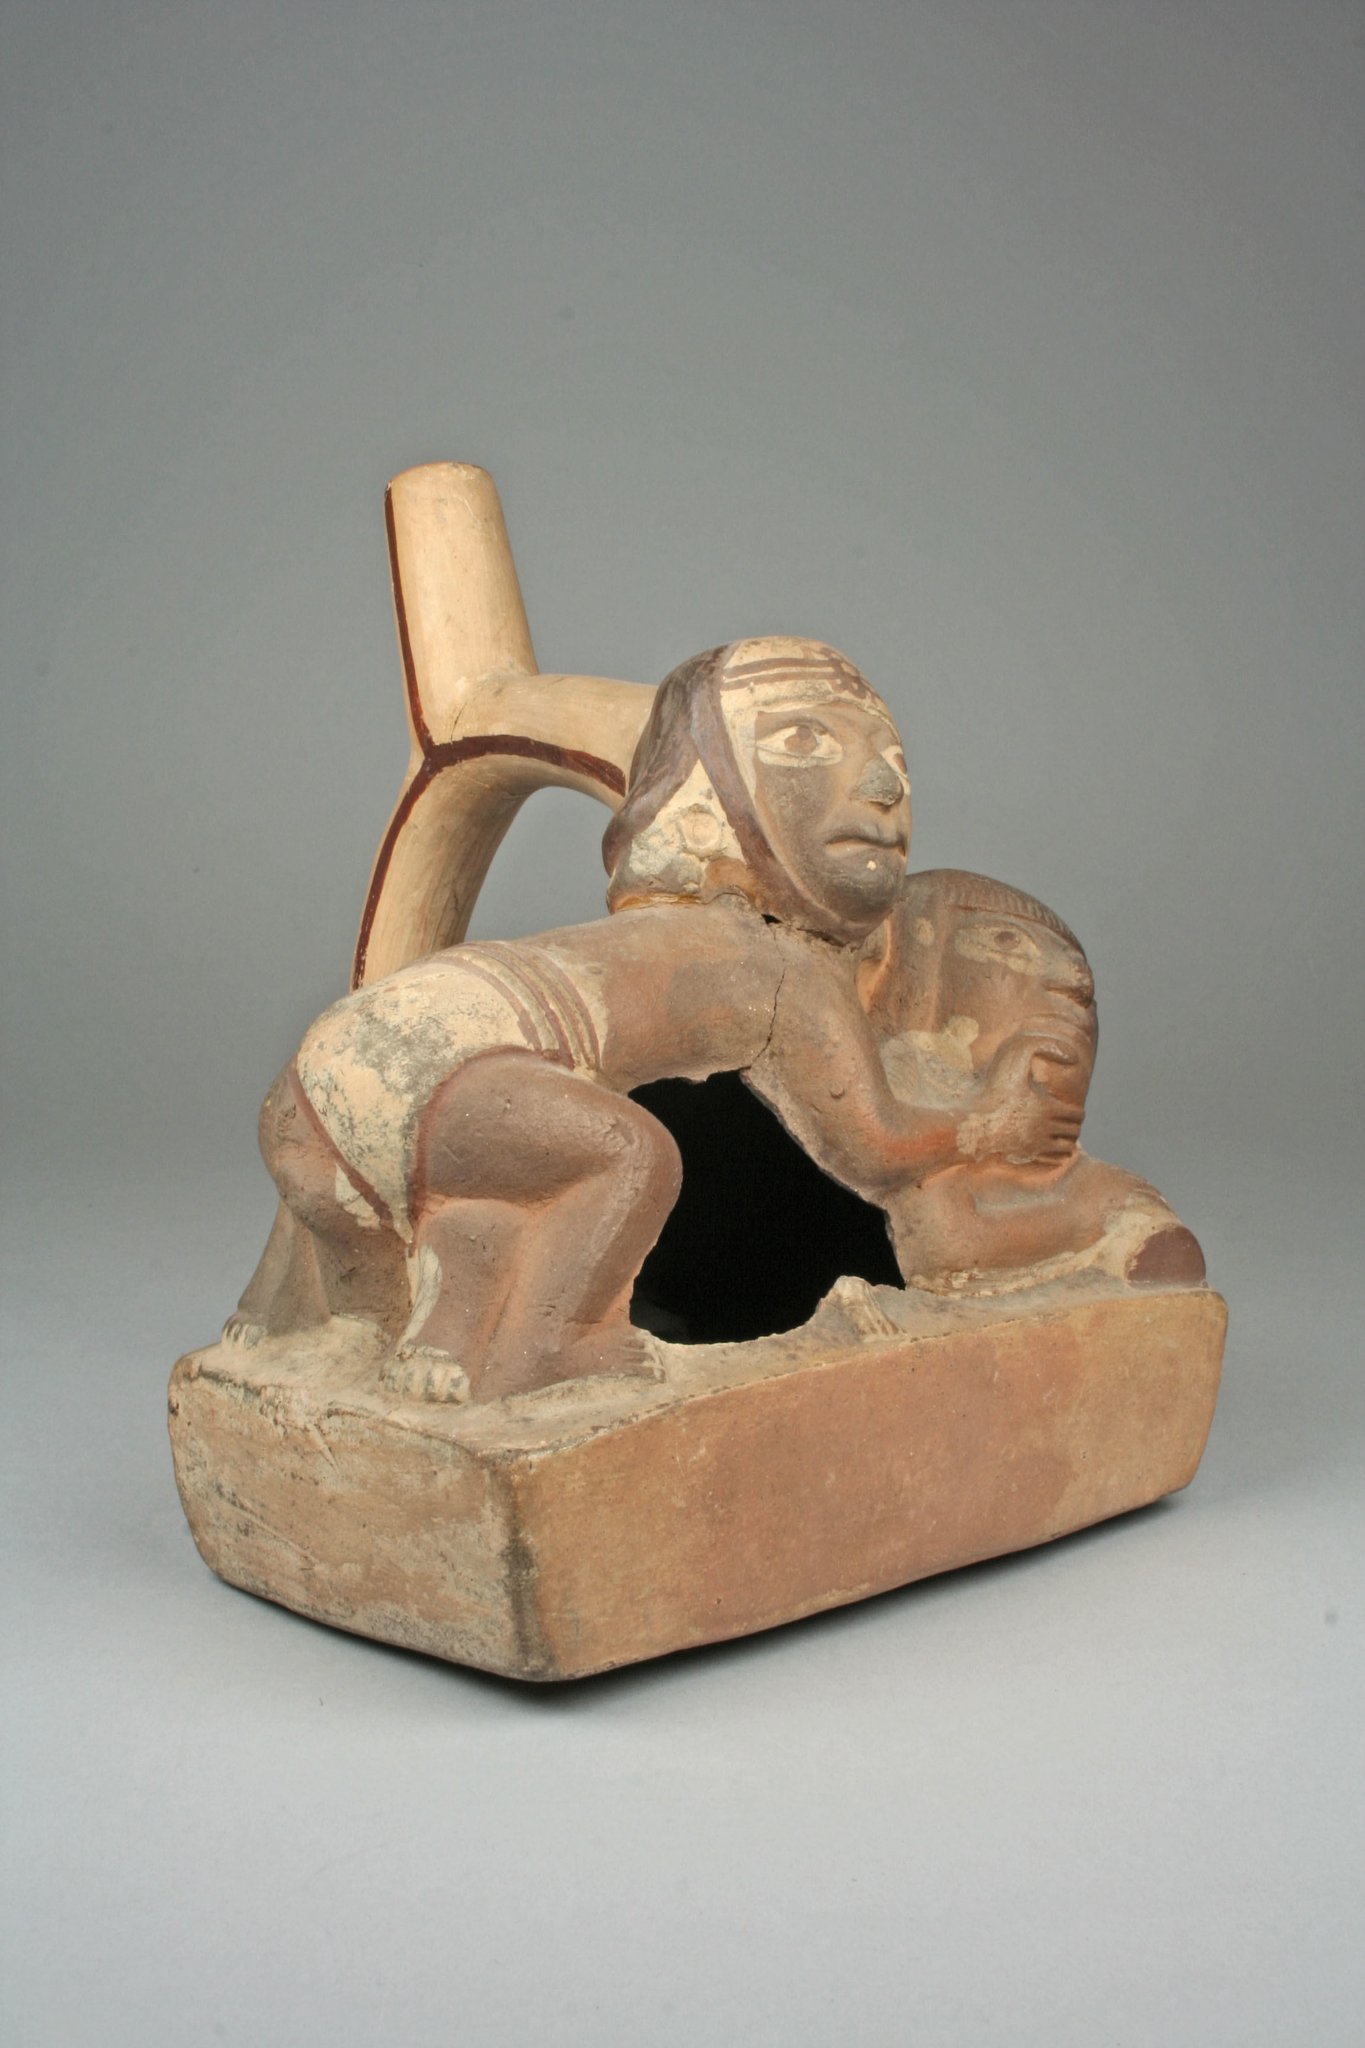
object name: bottle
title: Stirrup Spout Bottle with Couple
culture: moche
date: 101-500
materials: ceramic, pigment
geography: peru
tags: couples